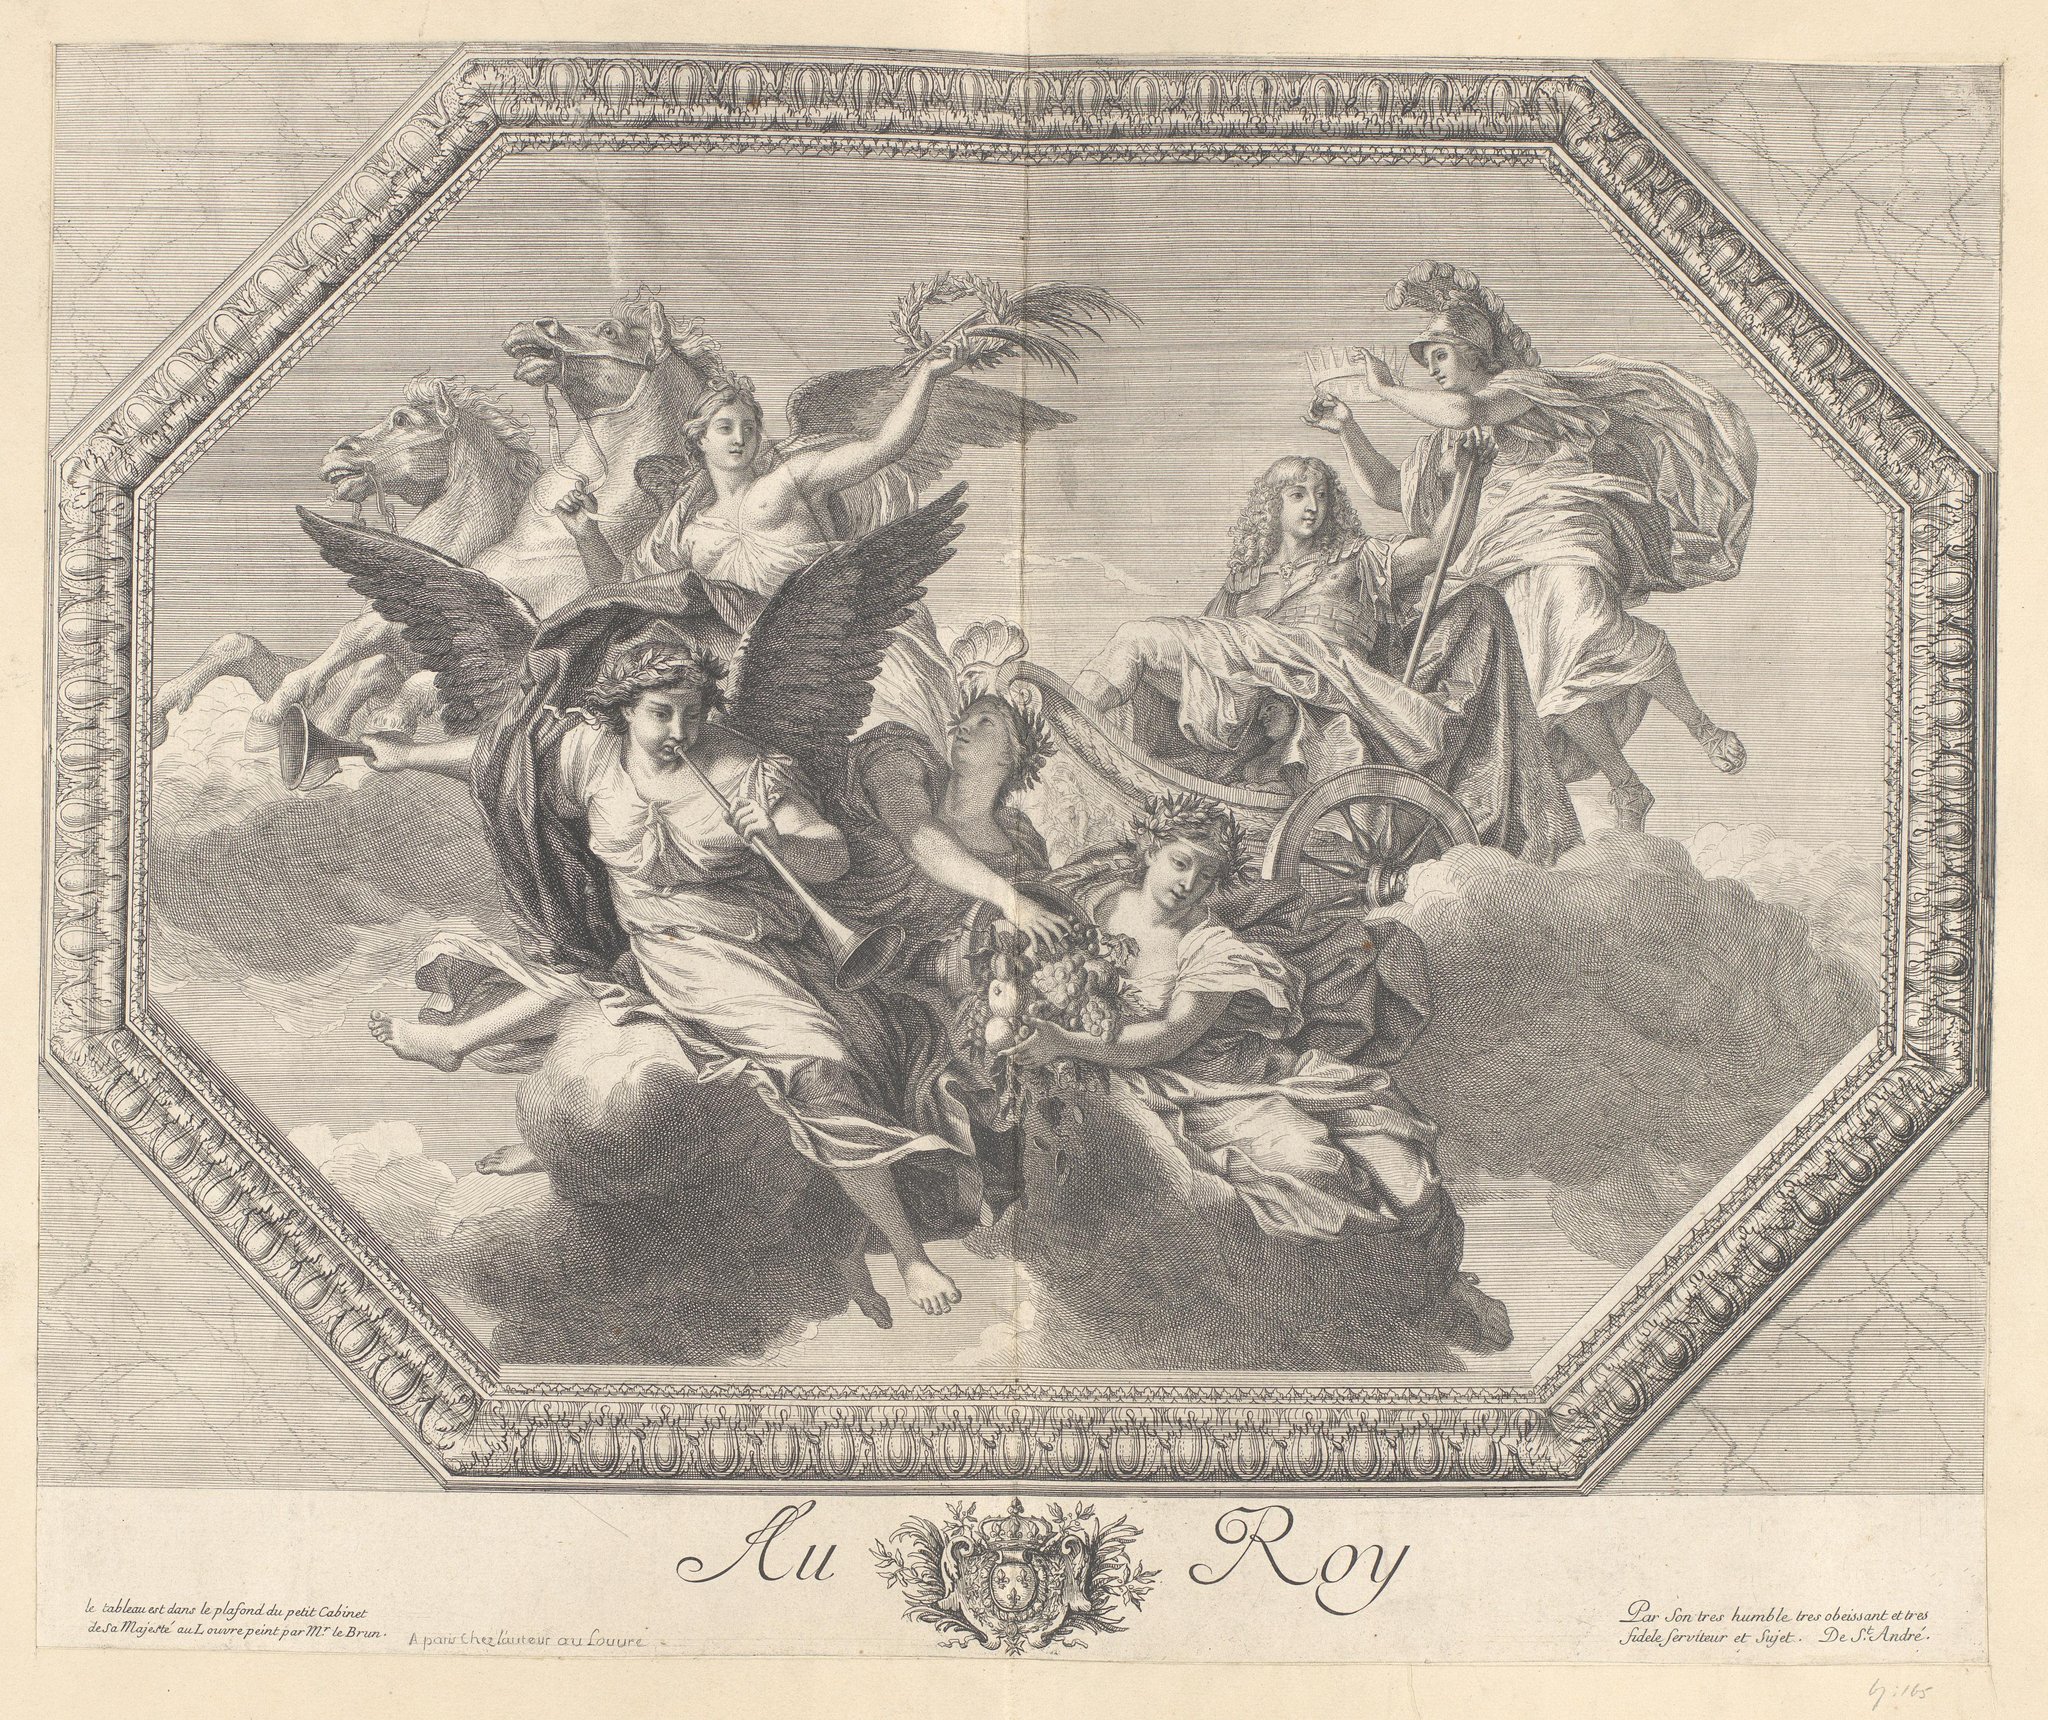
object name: print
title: Lodewijk XIV neemt het bestuur van de staat over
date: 1669-1695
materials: paper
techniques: engraving, etching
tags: lodewijk xiv (koning van frankrijk), ornaments ~ art, (decorated) ceiling, herald, installation of a ruler, paris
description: Plafondschildering in het Louvre. Deze prent maakt deel uit van een album.